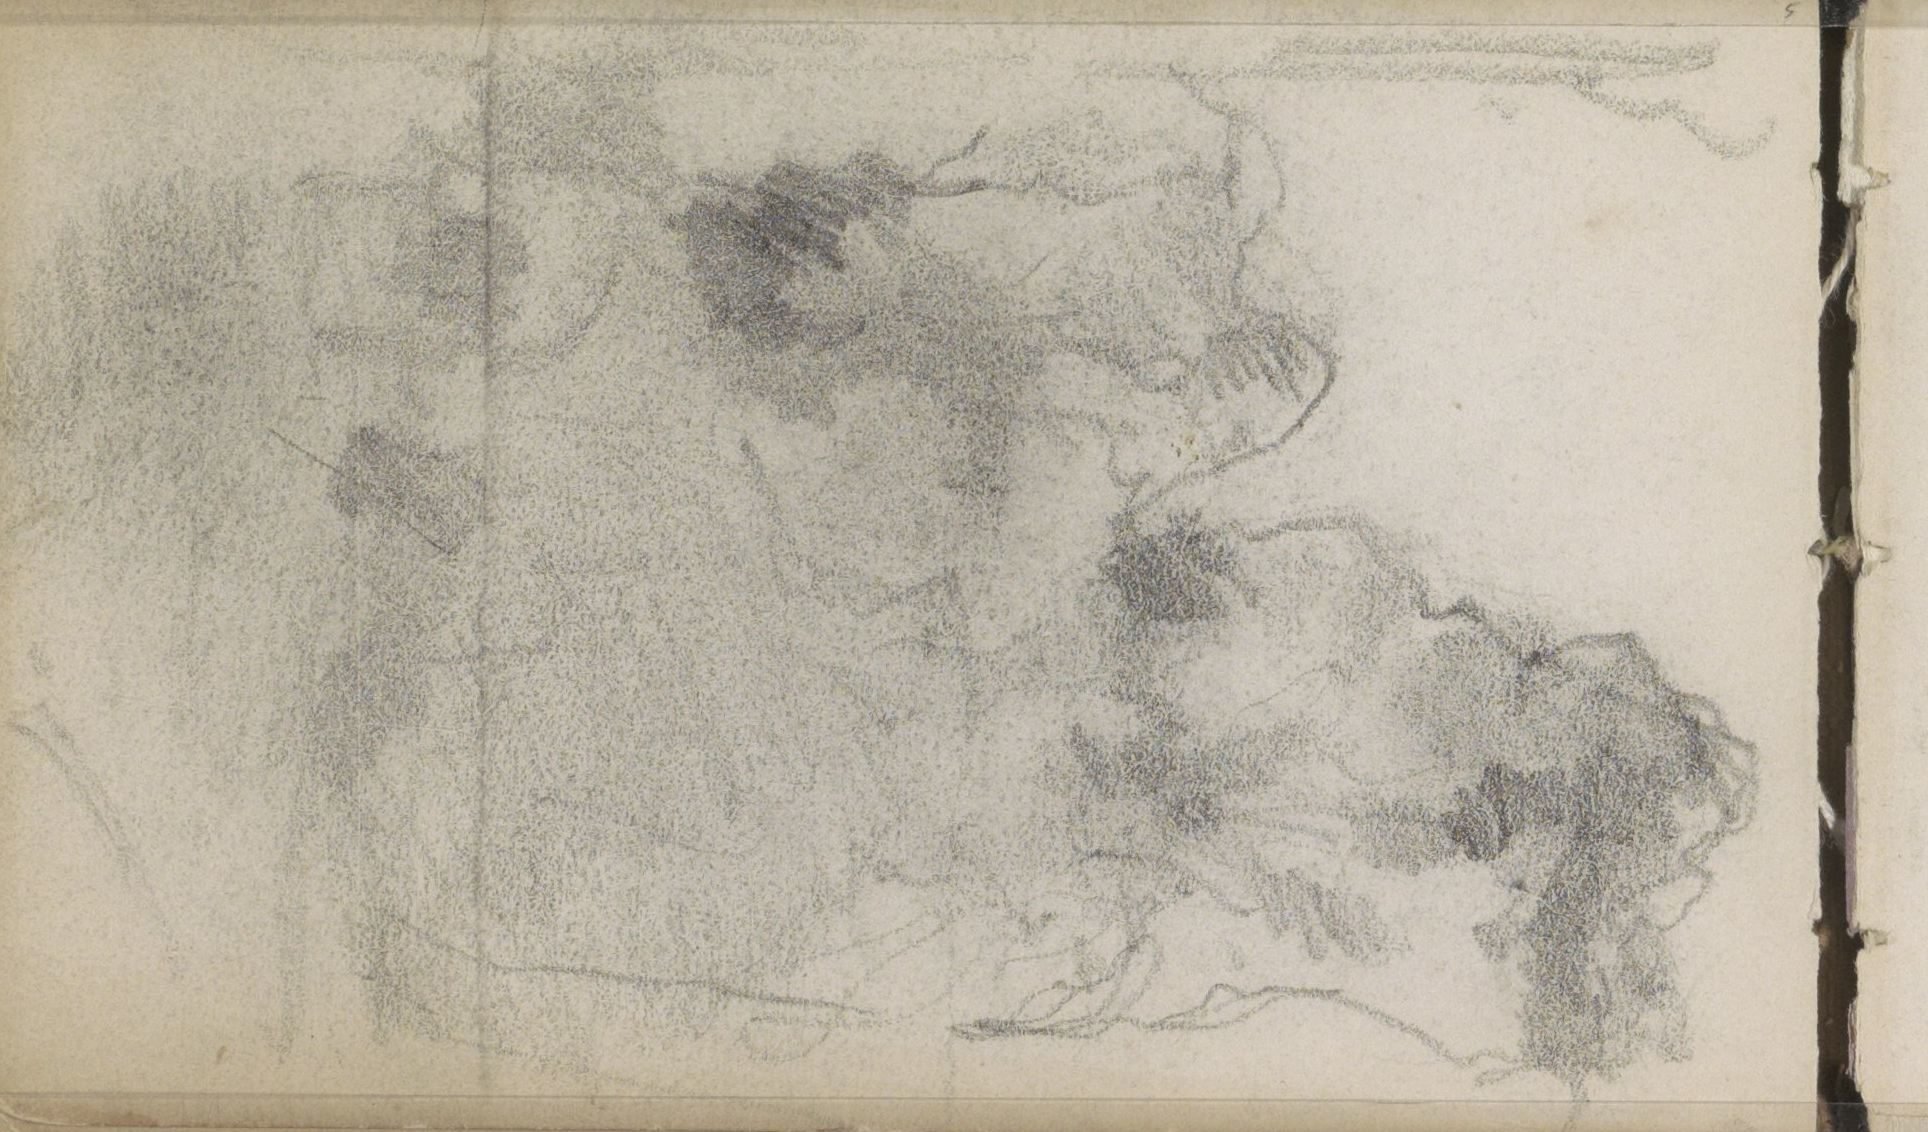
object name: sketchbook leaf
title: Landschap met bomen of wolkenlucht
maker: george hendrik breitner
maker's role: draughtsman, painter, print maker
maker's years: 1857-1923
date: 1881-1883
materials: paper, pencil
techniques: stumping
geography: north brabant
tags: trees, landscapes, clouds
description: Pagina 5 uit een schetsboek met 42 bladen.